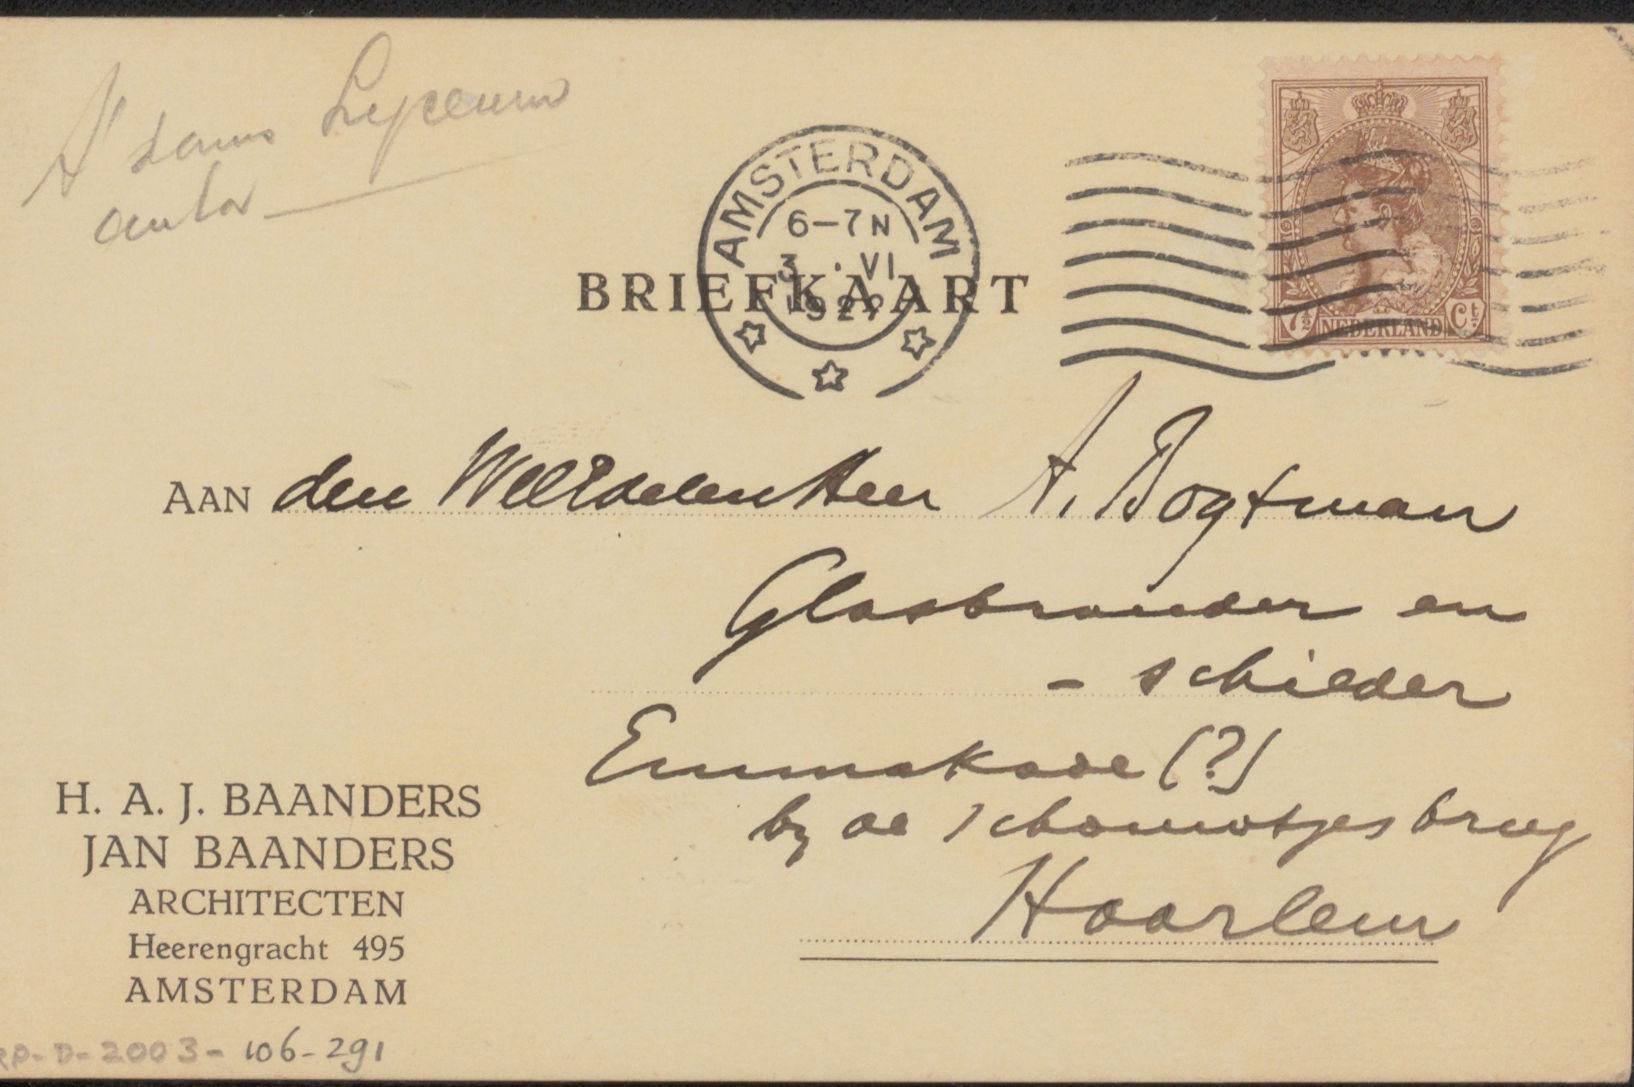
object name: postcard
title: Briefkaart aan Willem Bogtman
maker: herman ambrosius jan baanders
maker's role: architect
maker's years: 1876-1953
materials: cardboard, ink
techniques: pen, writing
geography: amsterdam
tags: bernard eilers, willem bogtman, richard nicolaüs roland holst, applied arts, arts and crafts; industrial design, photography, cinematography